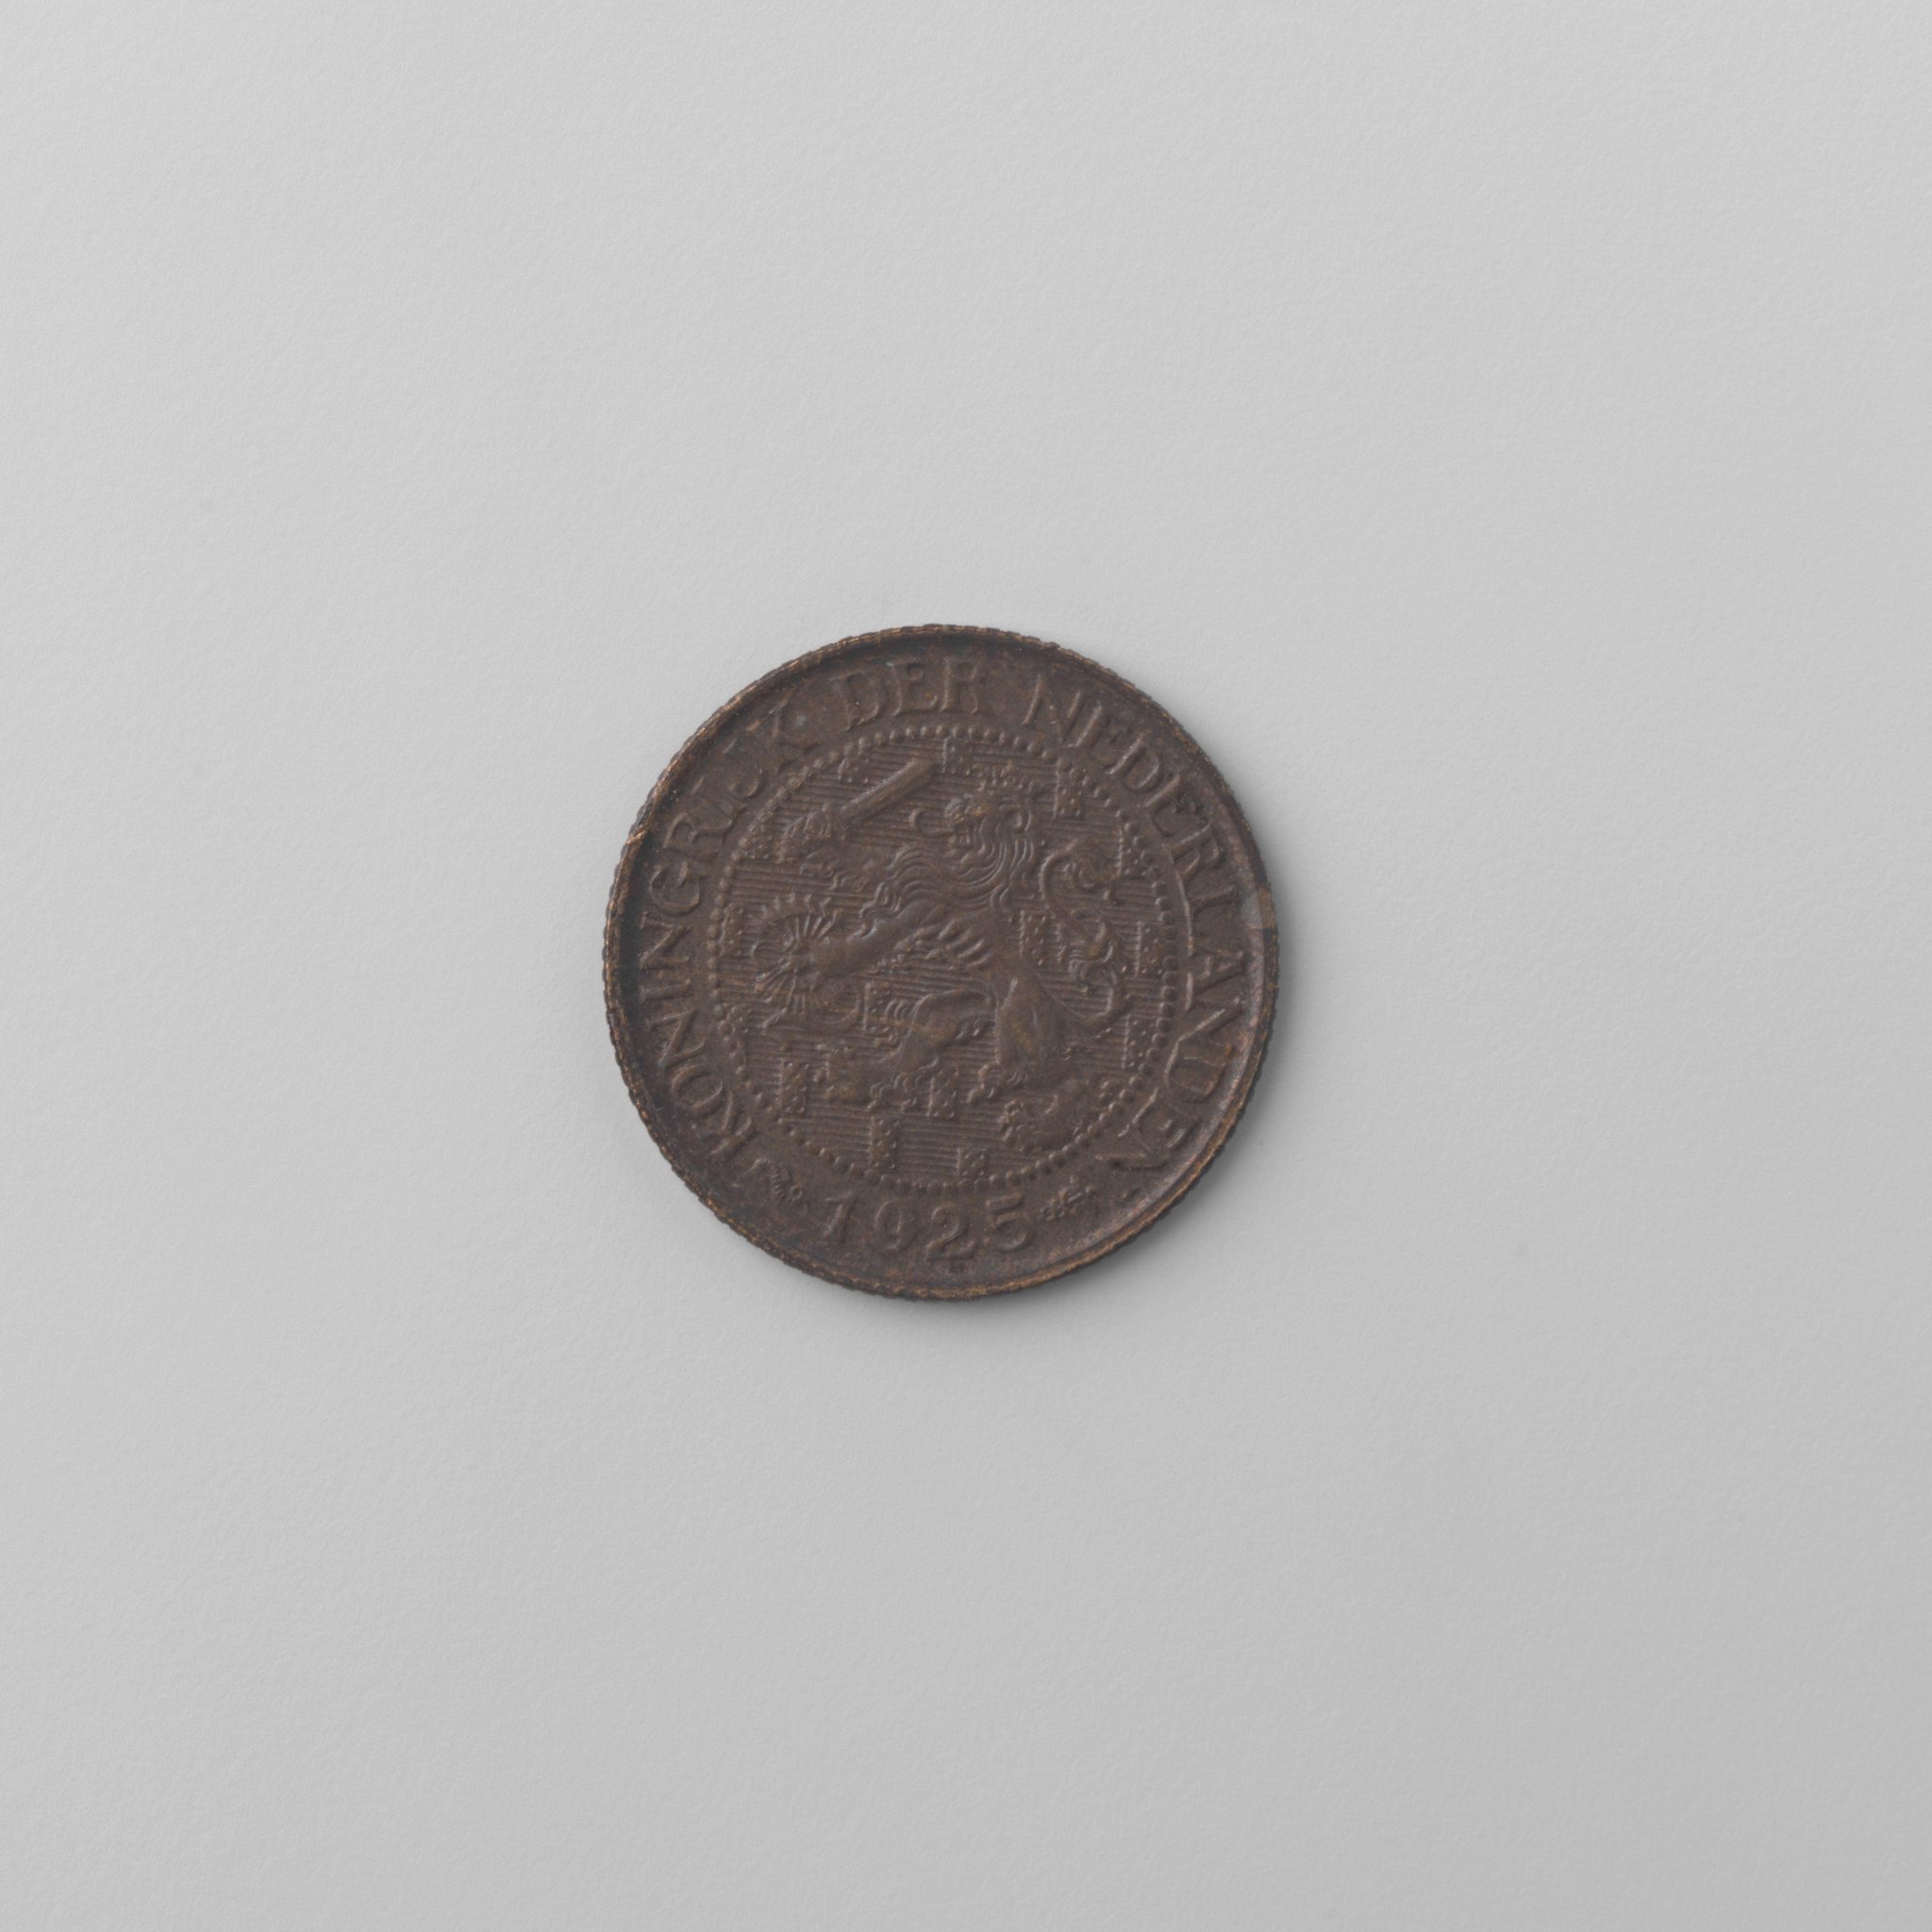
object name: coin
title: Nederlandse cent,1925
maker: wilhelmina of the netherlands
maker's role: print maker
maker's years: 1880-1962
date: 1925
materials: bronze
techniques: striking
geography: utrecht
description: Bronzen munt. Voorzijde: in een veld rijkswapen. Jaartal onderaan in omschrift. Keerzijde: binnen twee samengebonden oranjetakken waarde-aanduiding 1 cent. Kartelrand.